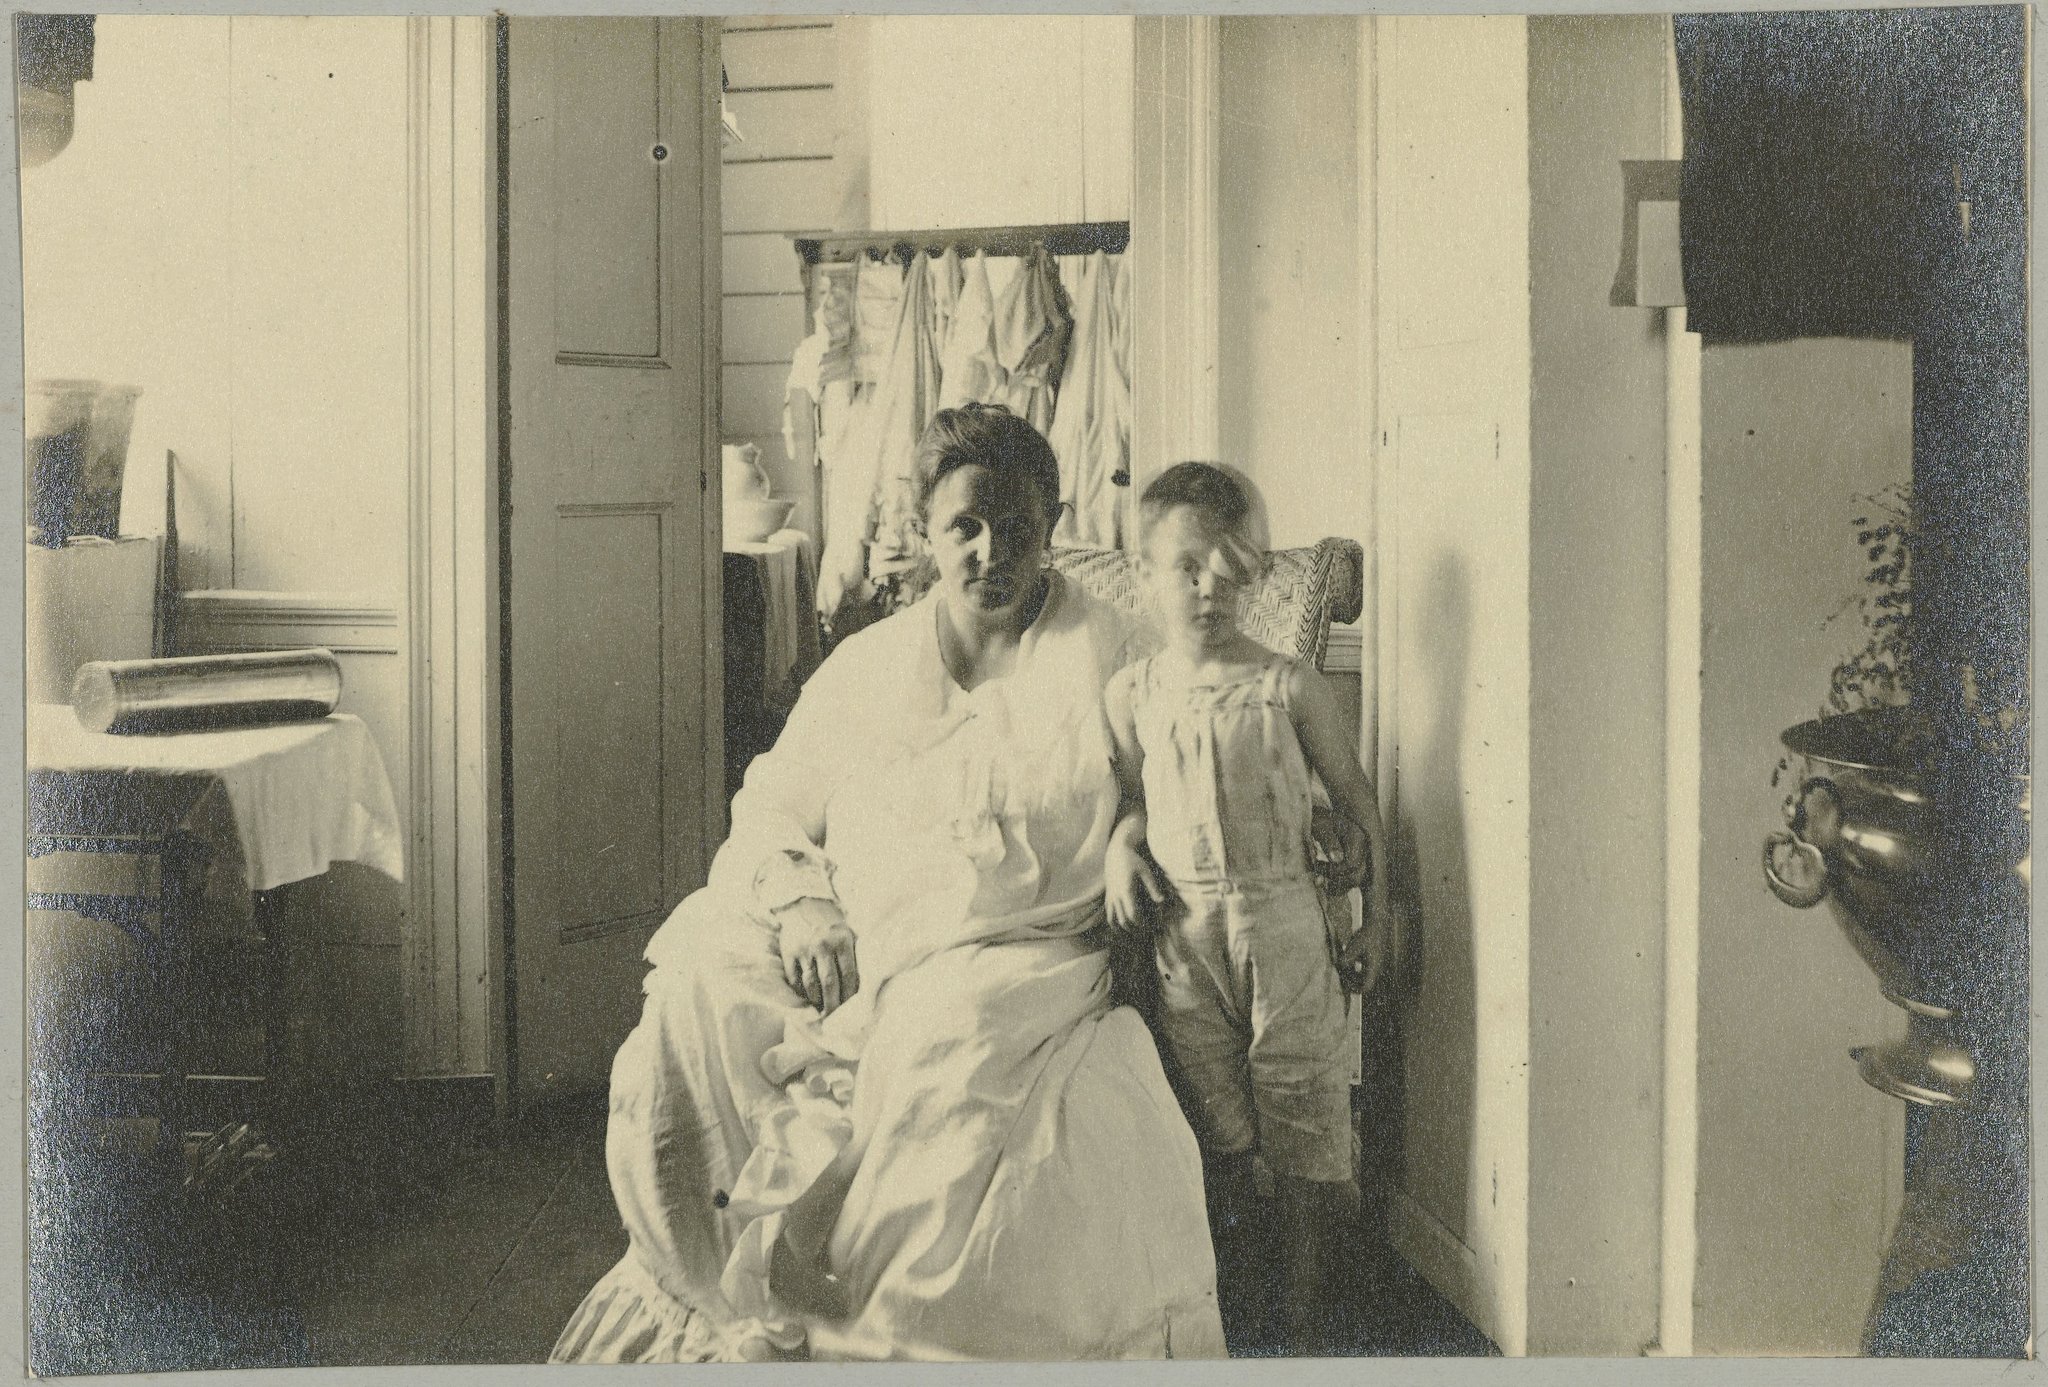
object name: photograph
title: Pim gekwetst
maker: hendrik doijer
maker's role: engineer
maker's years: 1863-1925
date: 1903-1910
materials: photographic support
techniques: gelatin silver print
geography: suriname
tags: suriname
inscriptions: inscription: ‘C17 / Pim gekwetst.’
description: Interieur met de Nederlandse jongen genaamd Pim, gewond aan het oog, staande naast zijn moeder. Onderdeel van het fotoalbum Souvenir de Voyage (deel 2), over het leven van de familie Doijer in en rond de plantage Ma Retraite in Suriname in de jaren 1903-1910.